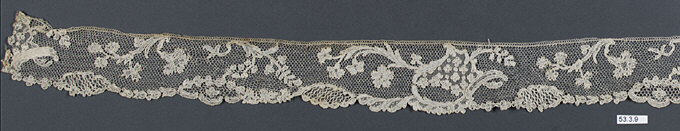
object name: border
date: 1751-1800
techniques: lace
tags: flowers